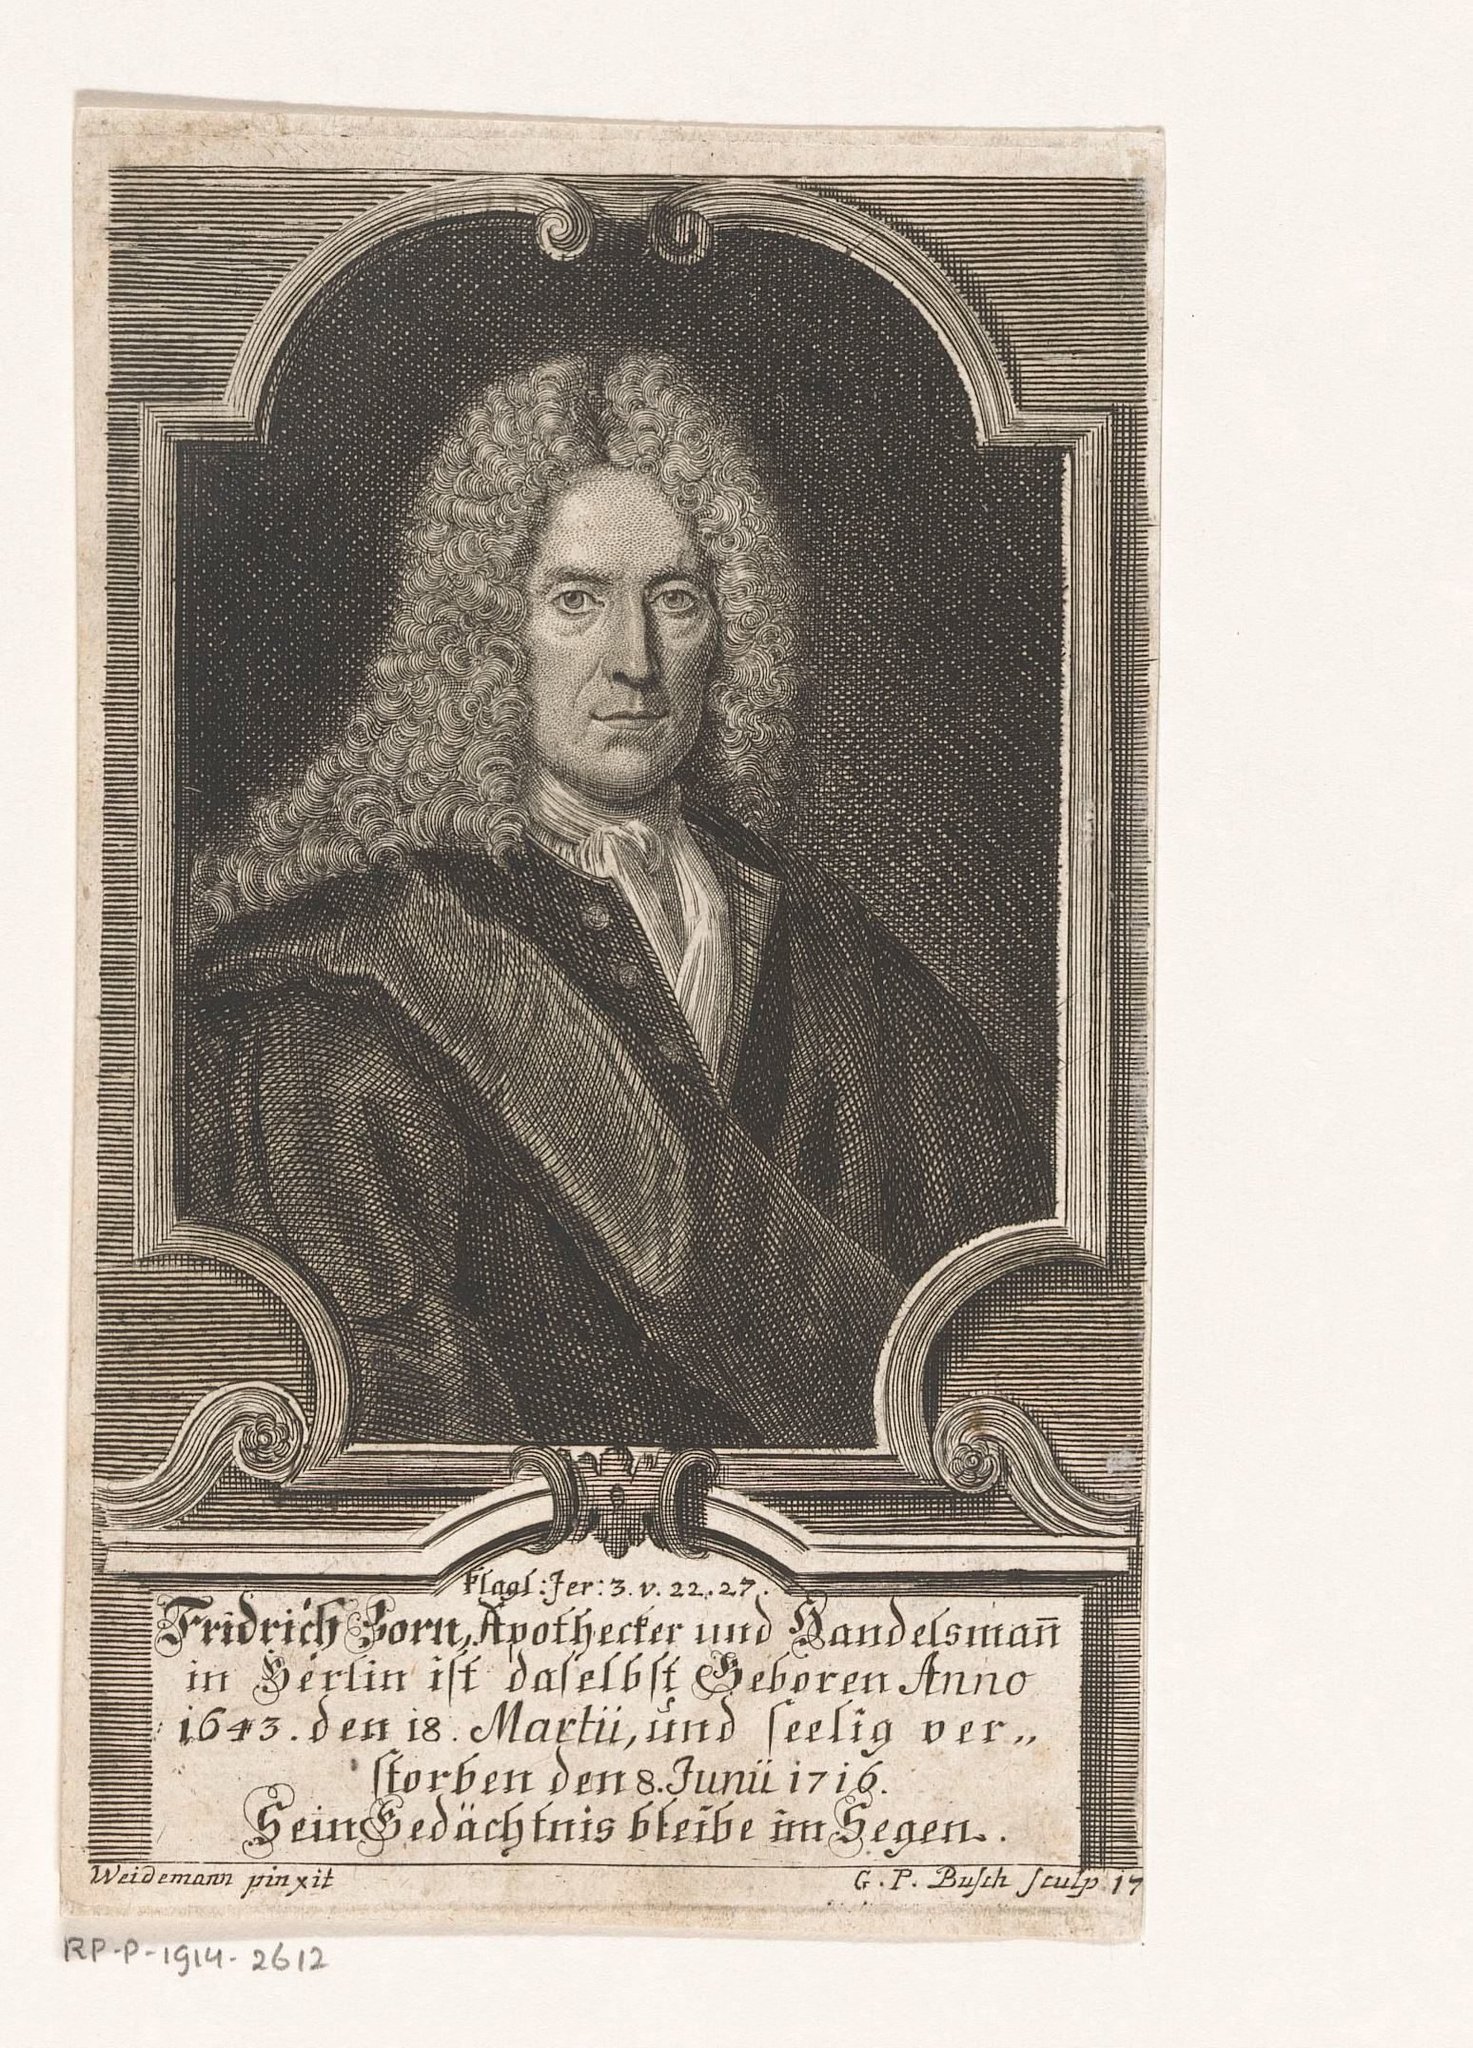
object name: print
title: Portret van Friedrich Zorn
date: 1719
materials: paper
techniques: engraving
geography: berlin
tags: berlin, historical persons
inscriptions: collector's mark: Lugt 2228